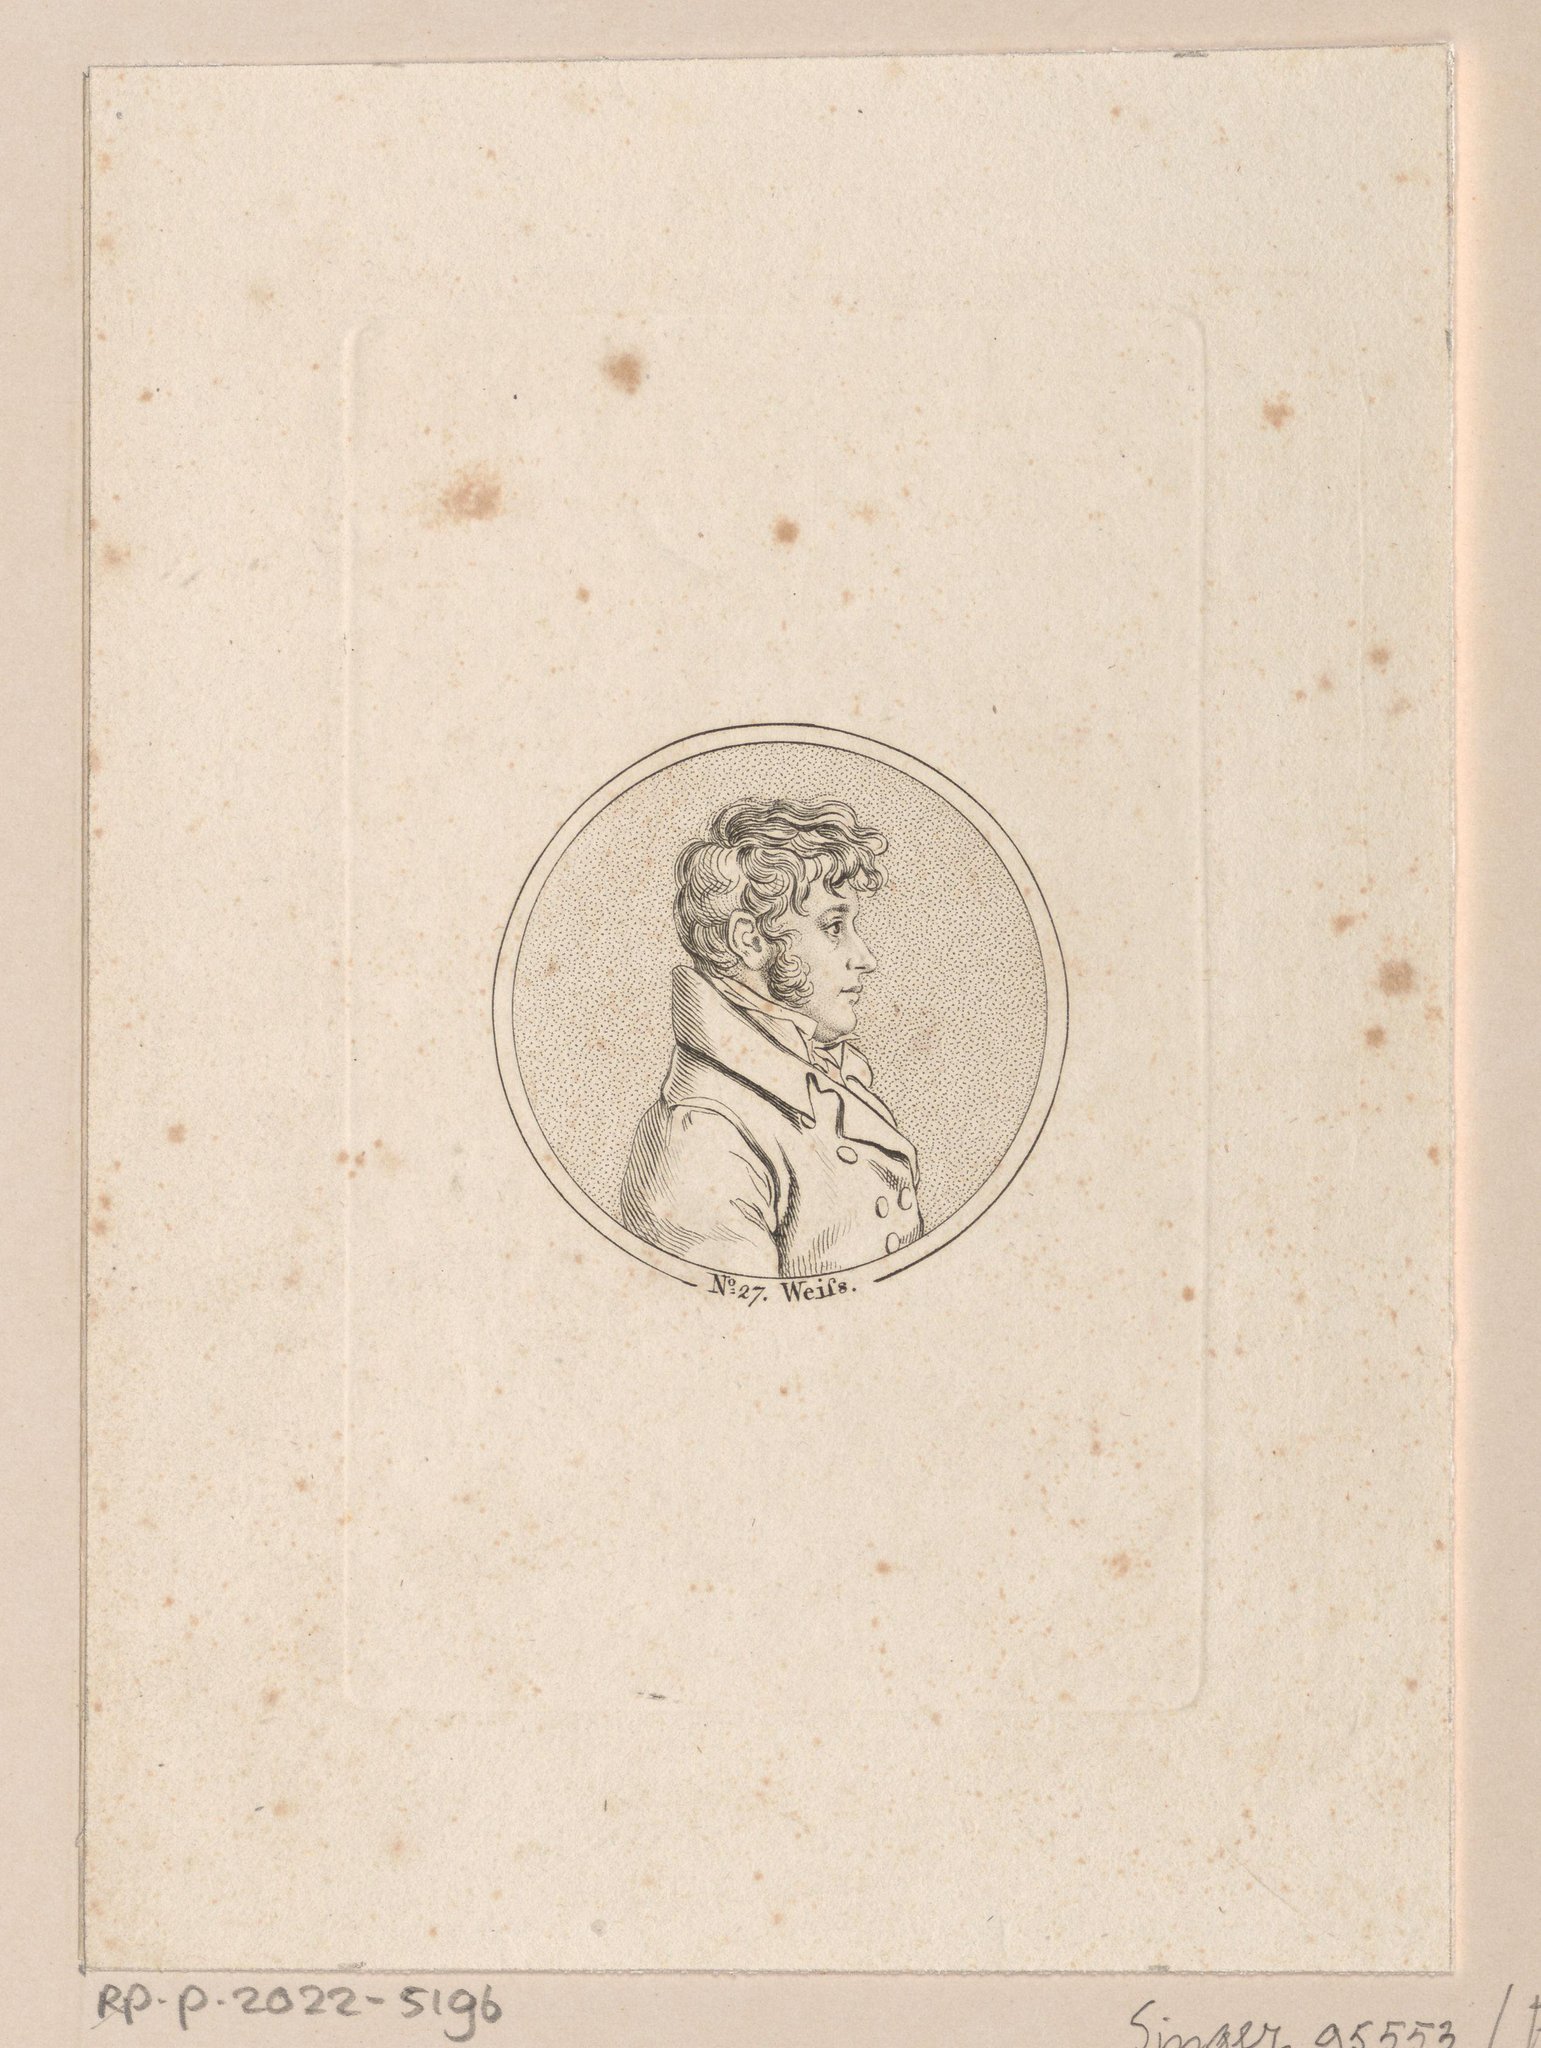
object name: book illustration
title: Portret van Christian Samuel Weiss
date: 1810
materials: paper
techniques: etching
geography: leipzig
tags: historical persons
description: Prent uit: Kreussler, Heinrich Gottlieb. Autobiographieen Leipziger Gelehrten. Leipzig: J.B. Fleischer, 1810.